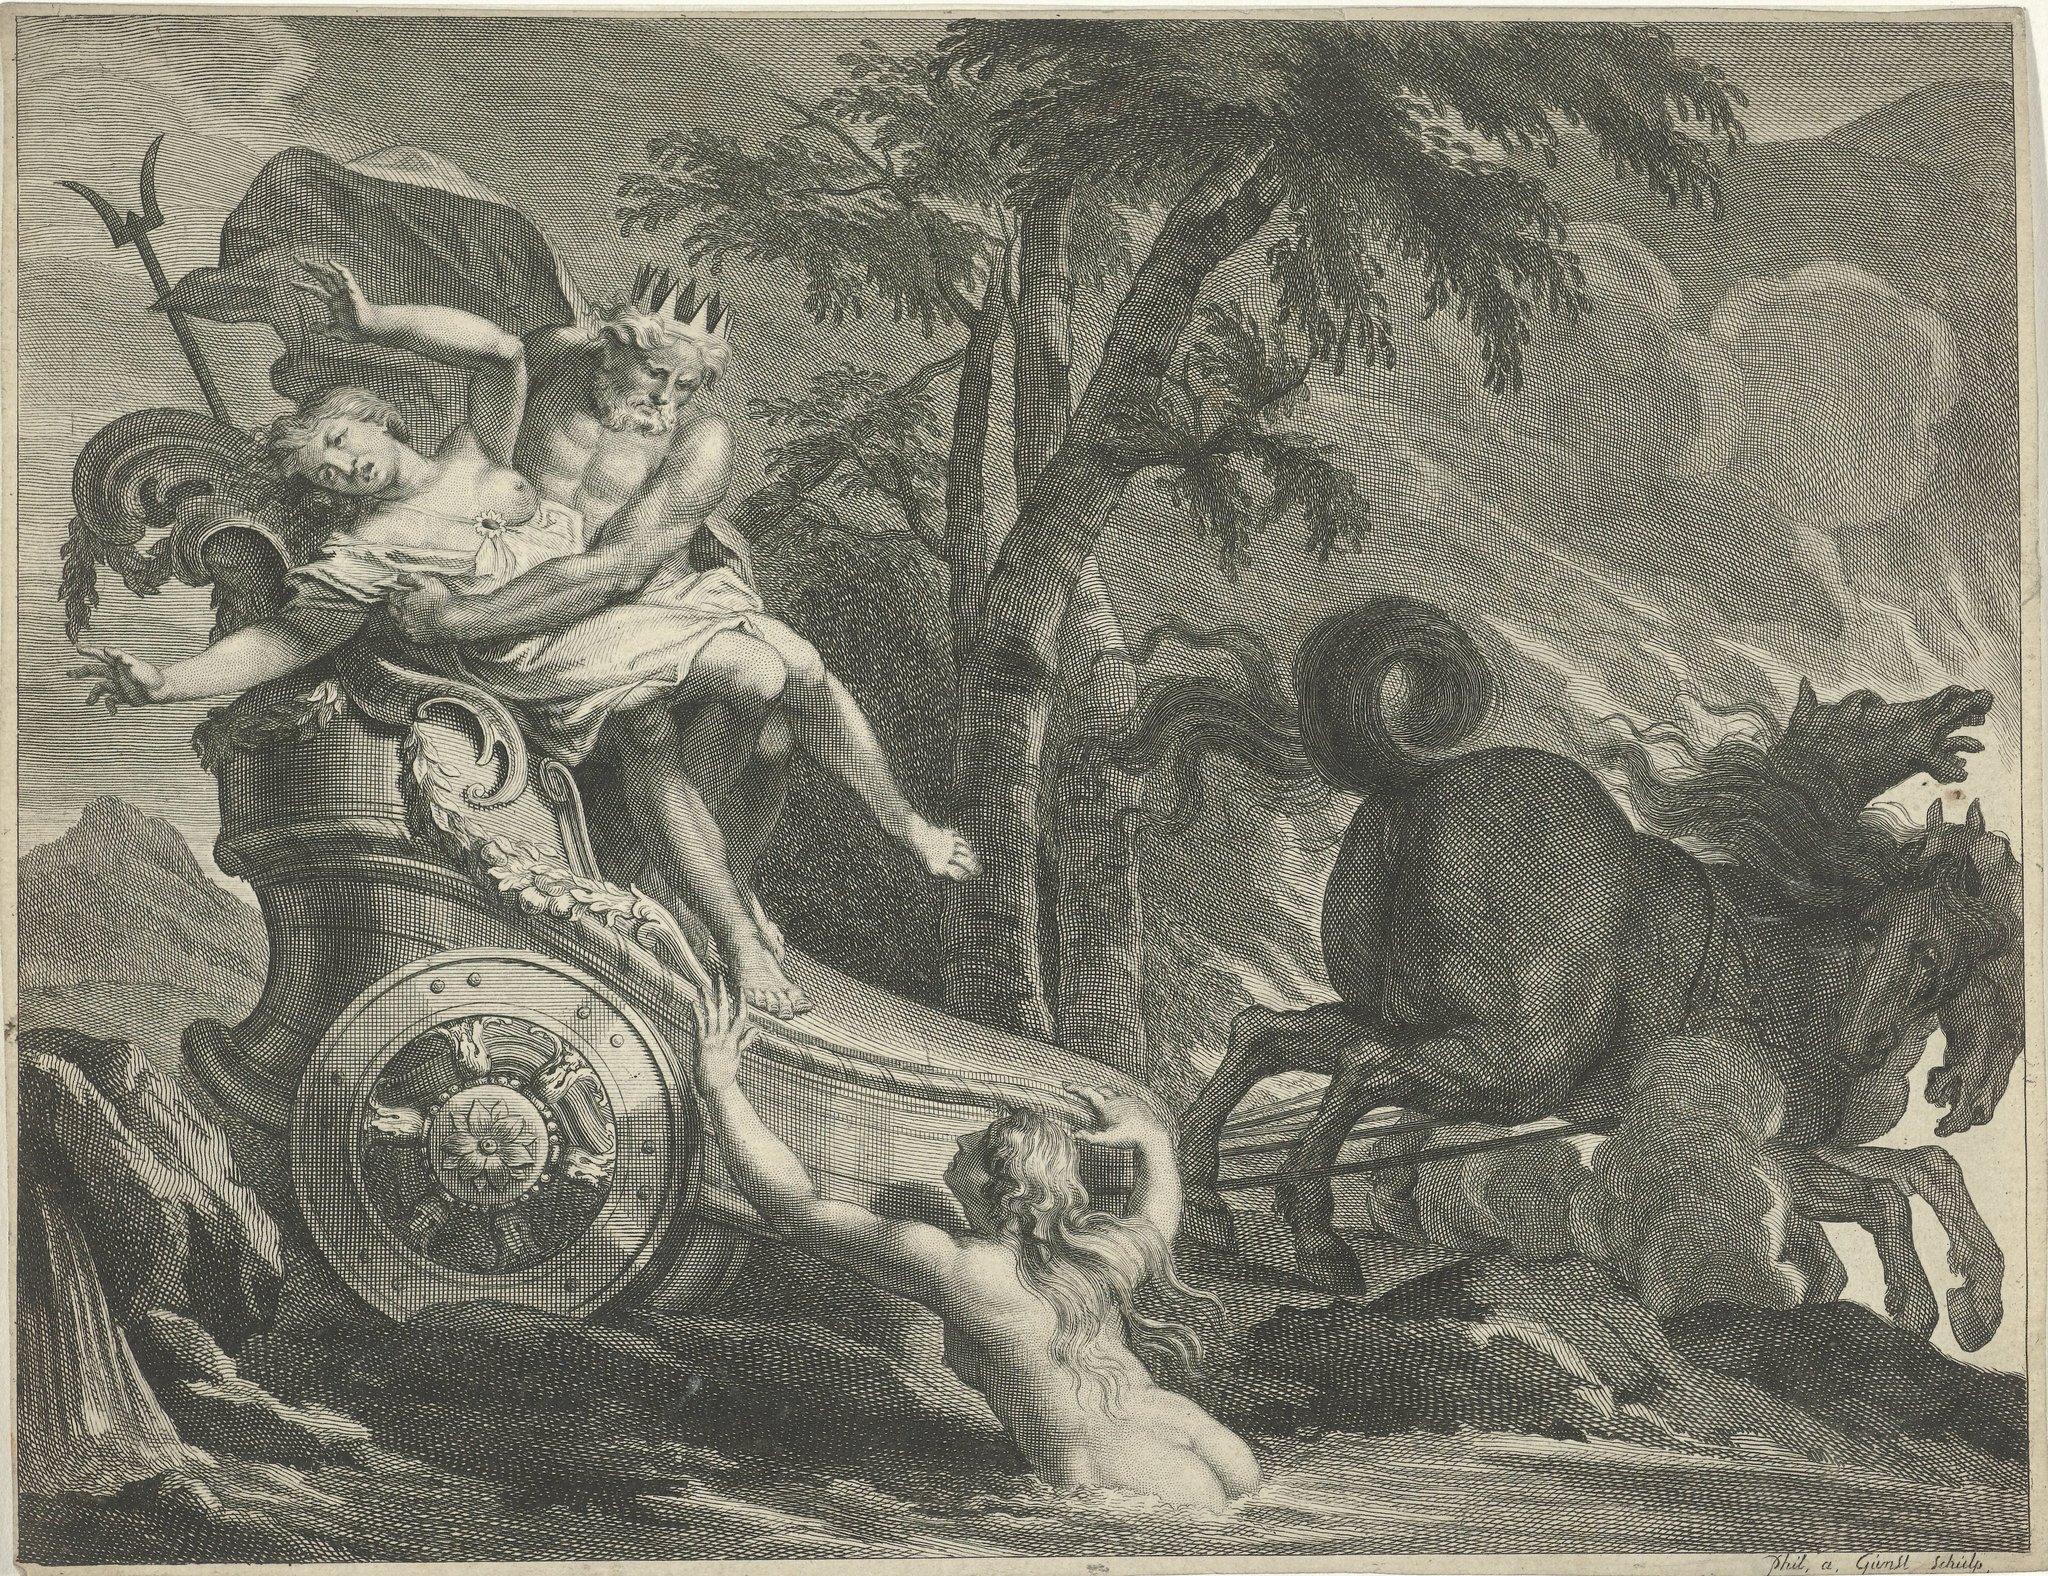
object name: print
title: Roof van Proserpina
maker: philip van gunst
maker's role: print maker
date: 1685-1732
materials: paper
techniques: engraving, etching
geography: amsterdam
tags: the rape of proserpina (by pluto in his chariot); possibly with diana and minerva trying to rescue her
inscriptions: collector's mark: Lugt 2228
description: Pluto sleurt Proserpina, de dochter van Ceres, op zijn wagen en rijdt richting de vlammen van de onderwereld. Een van Proserpina haar nimfen tracht hem tegen te houden.